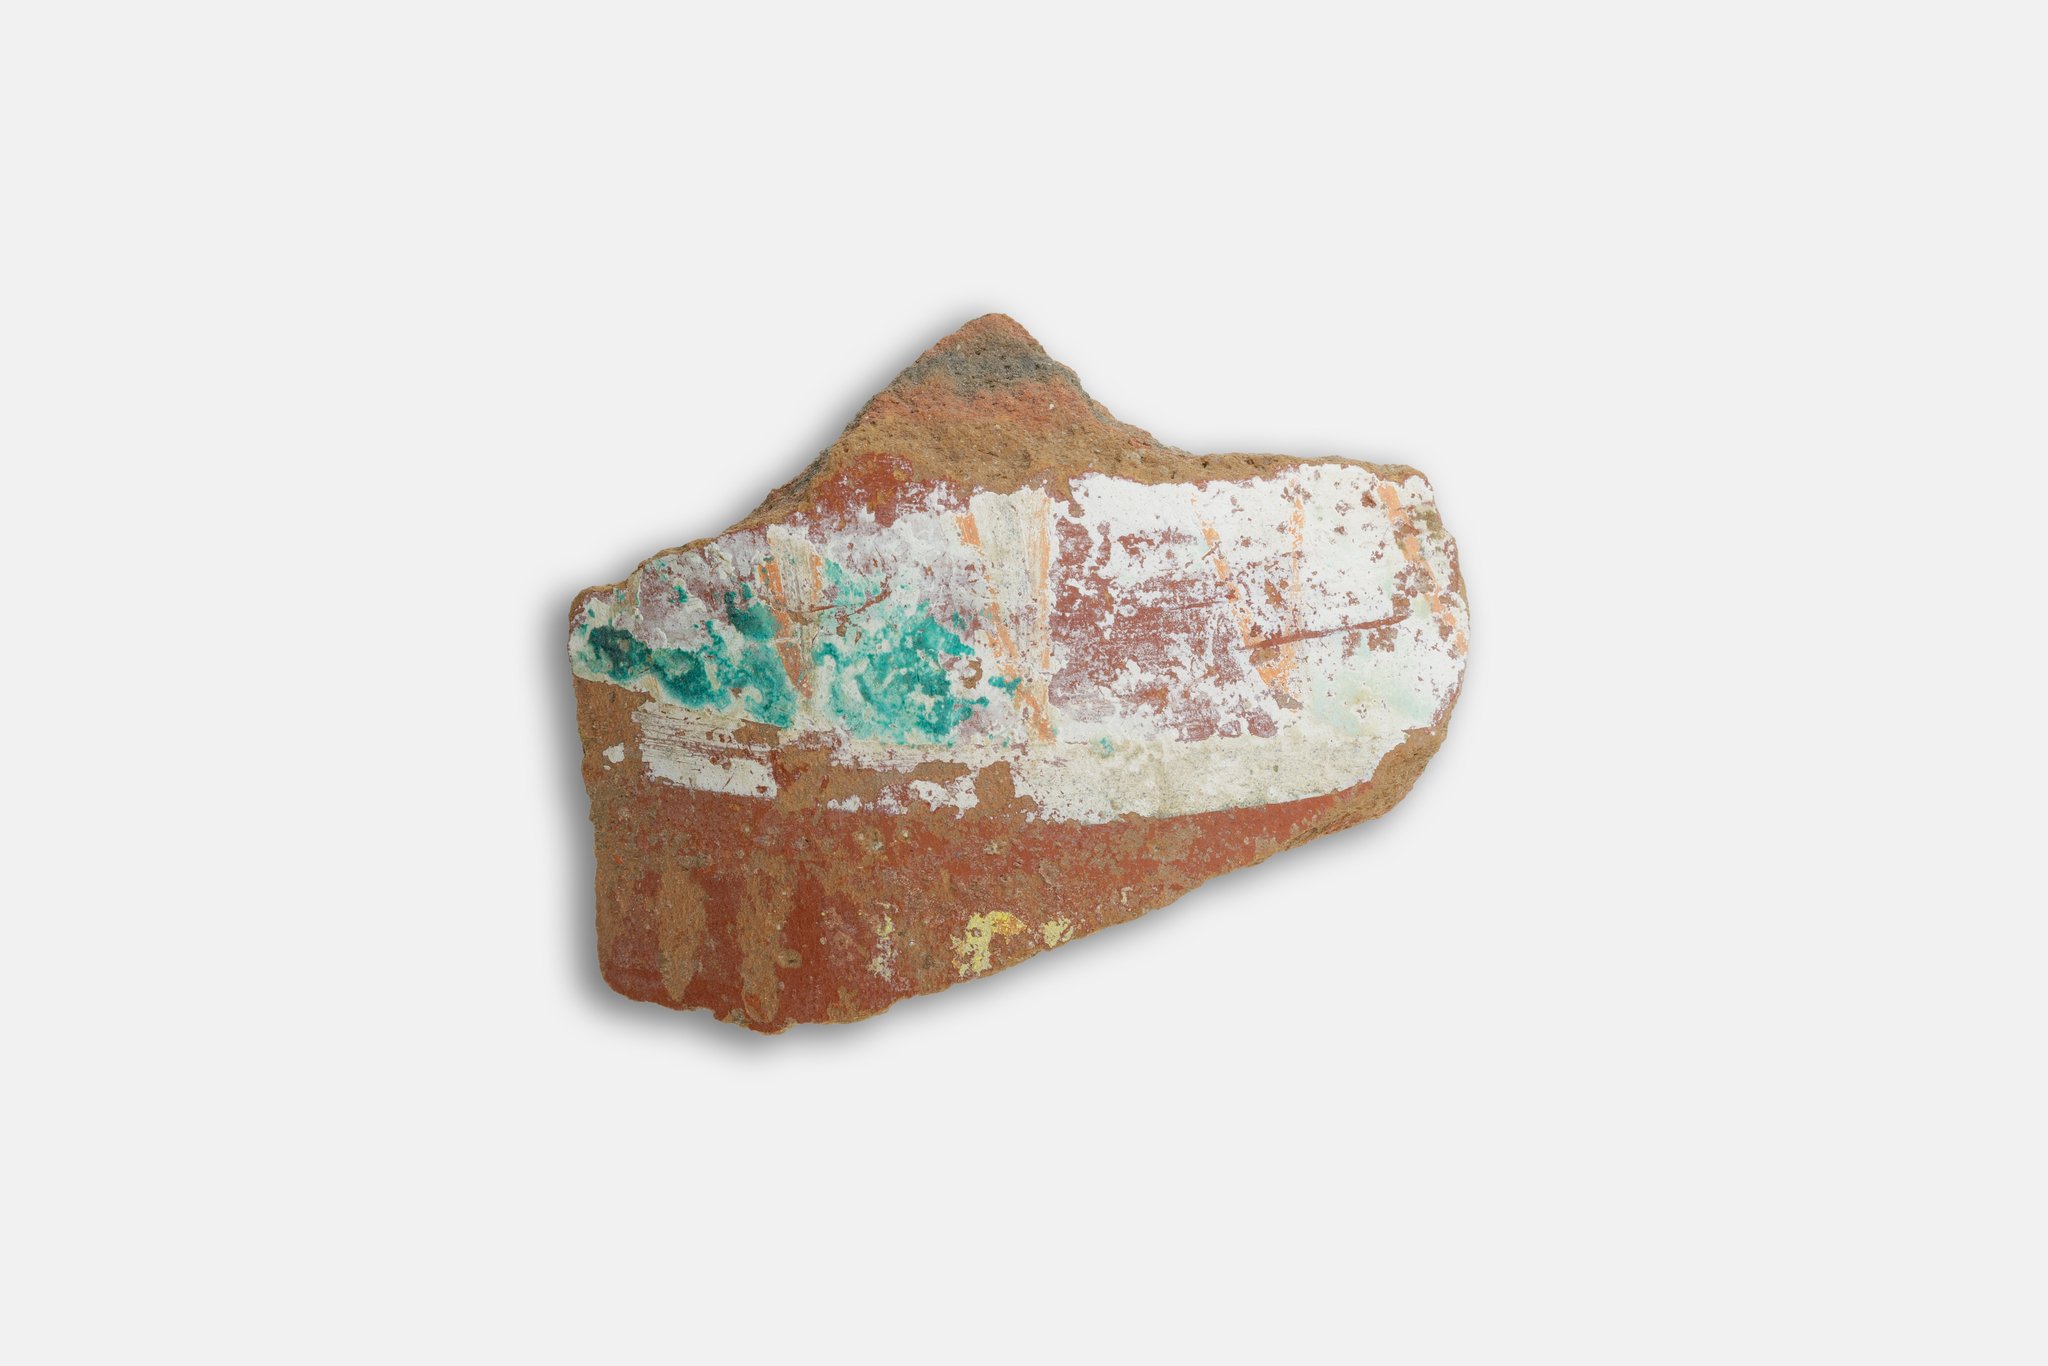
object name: jar fragment, malqata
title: Decorated jar fragment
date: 1390-1352 BCE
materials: ink, paint, pottery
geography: egypt